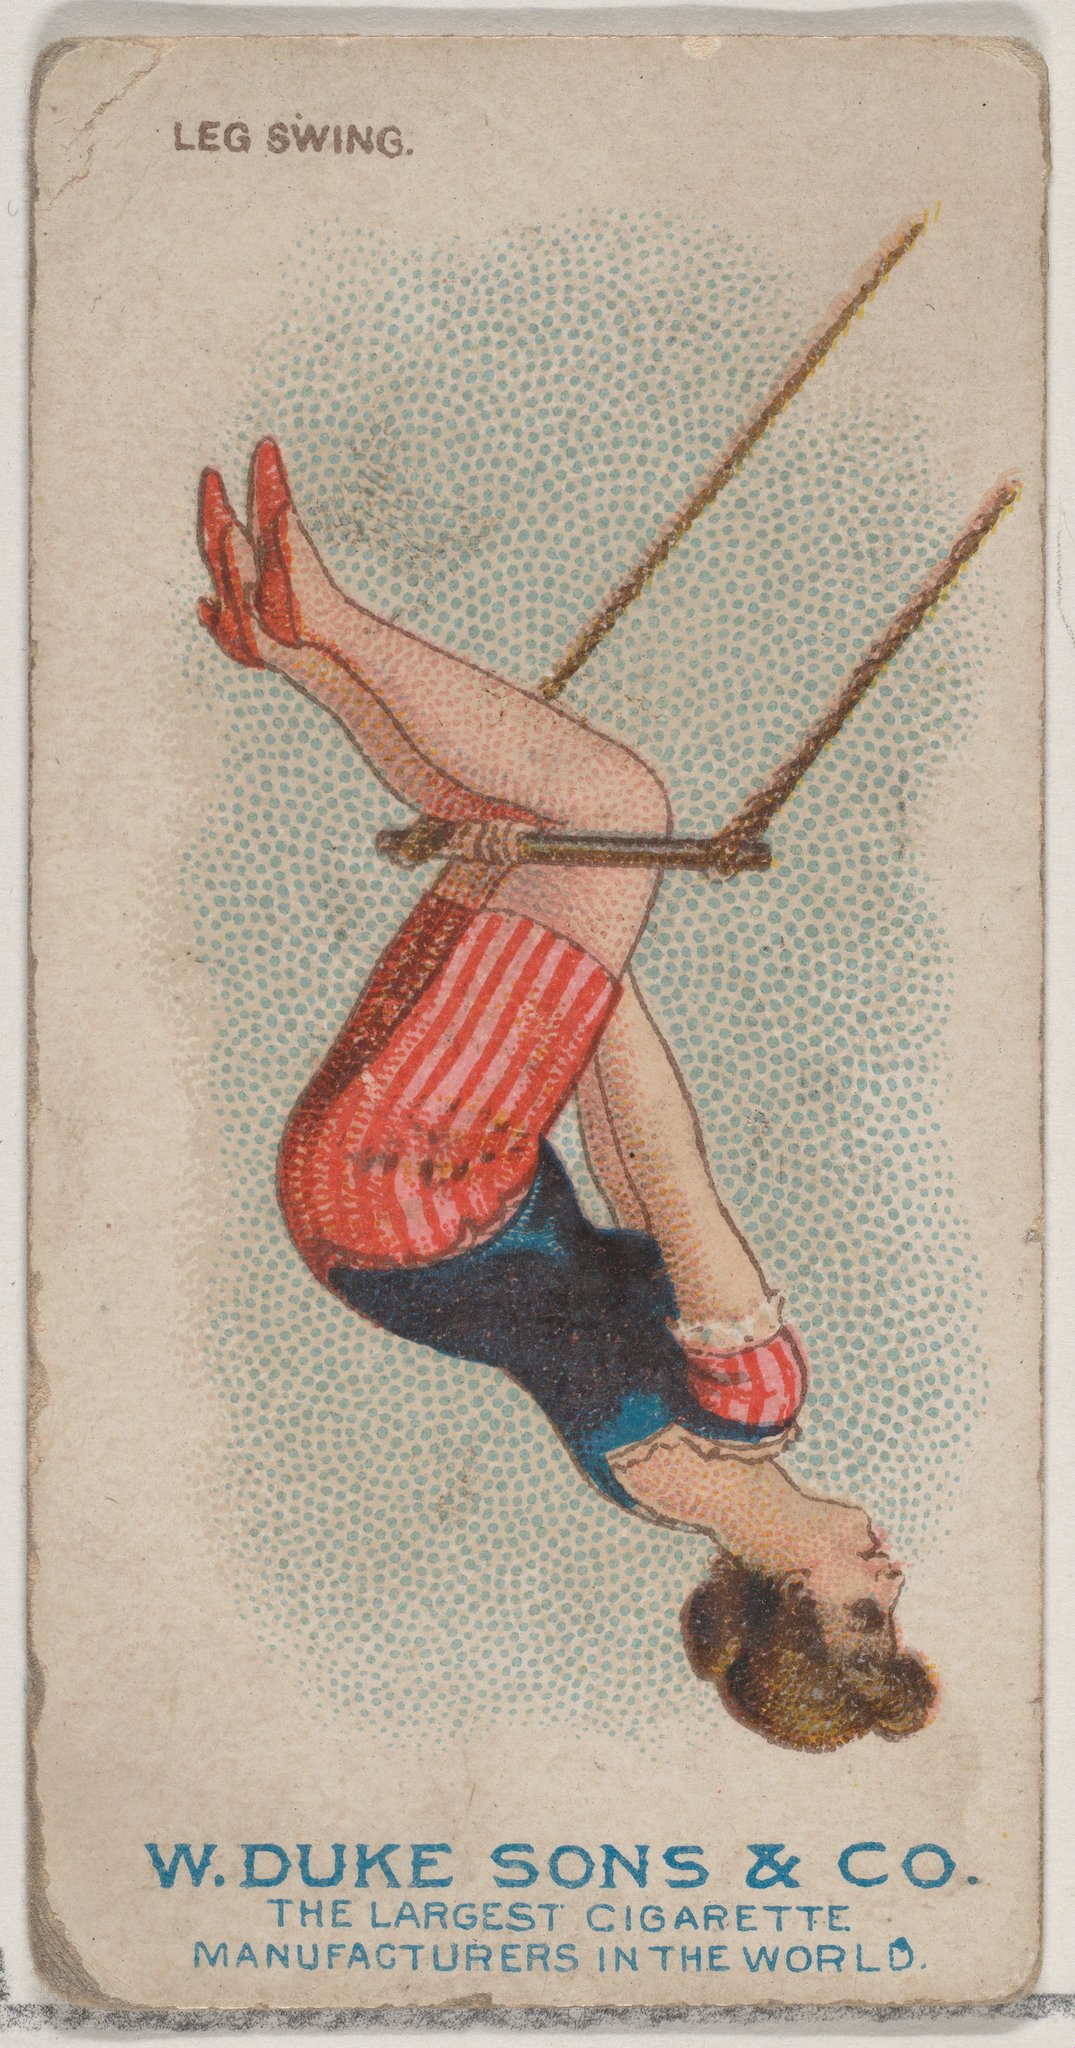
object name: print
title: Leg Swing, from the Gymnastic Exercises series (N77) for Duke brand cigarettes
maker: w. duke, sons & co.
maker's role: publisher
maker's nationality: american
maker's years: 1870-1920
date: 1887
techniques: color lithograph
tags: women,sports,athletes